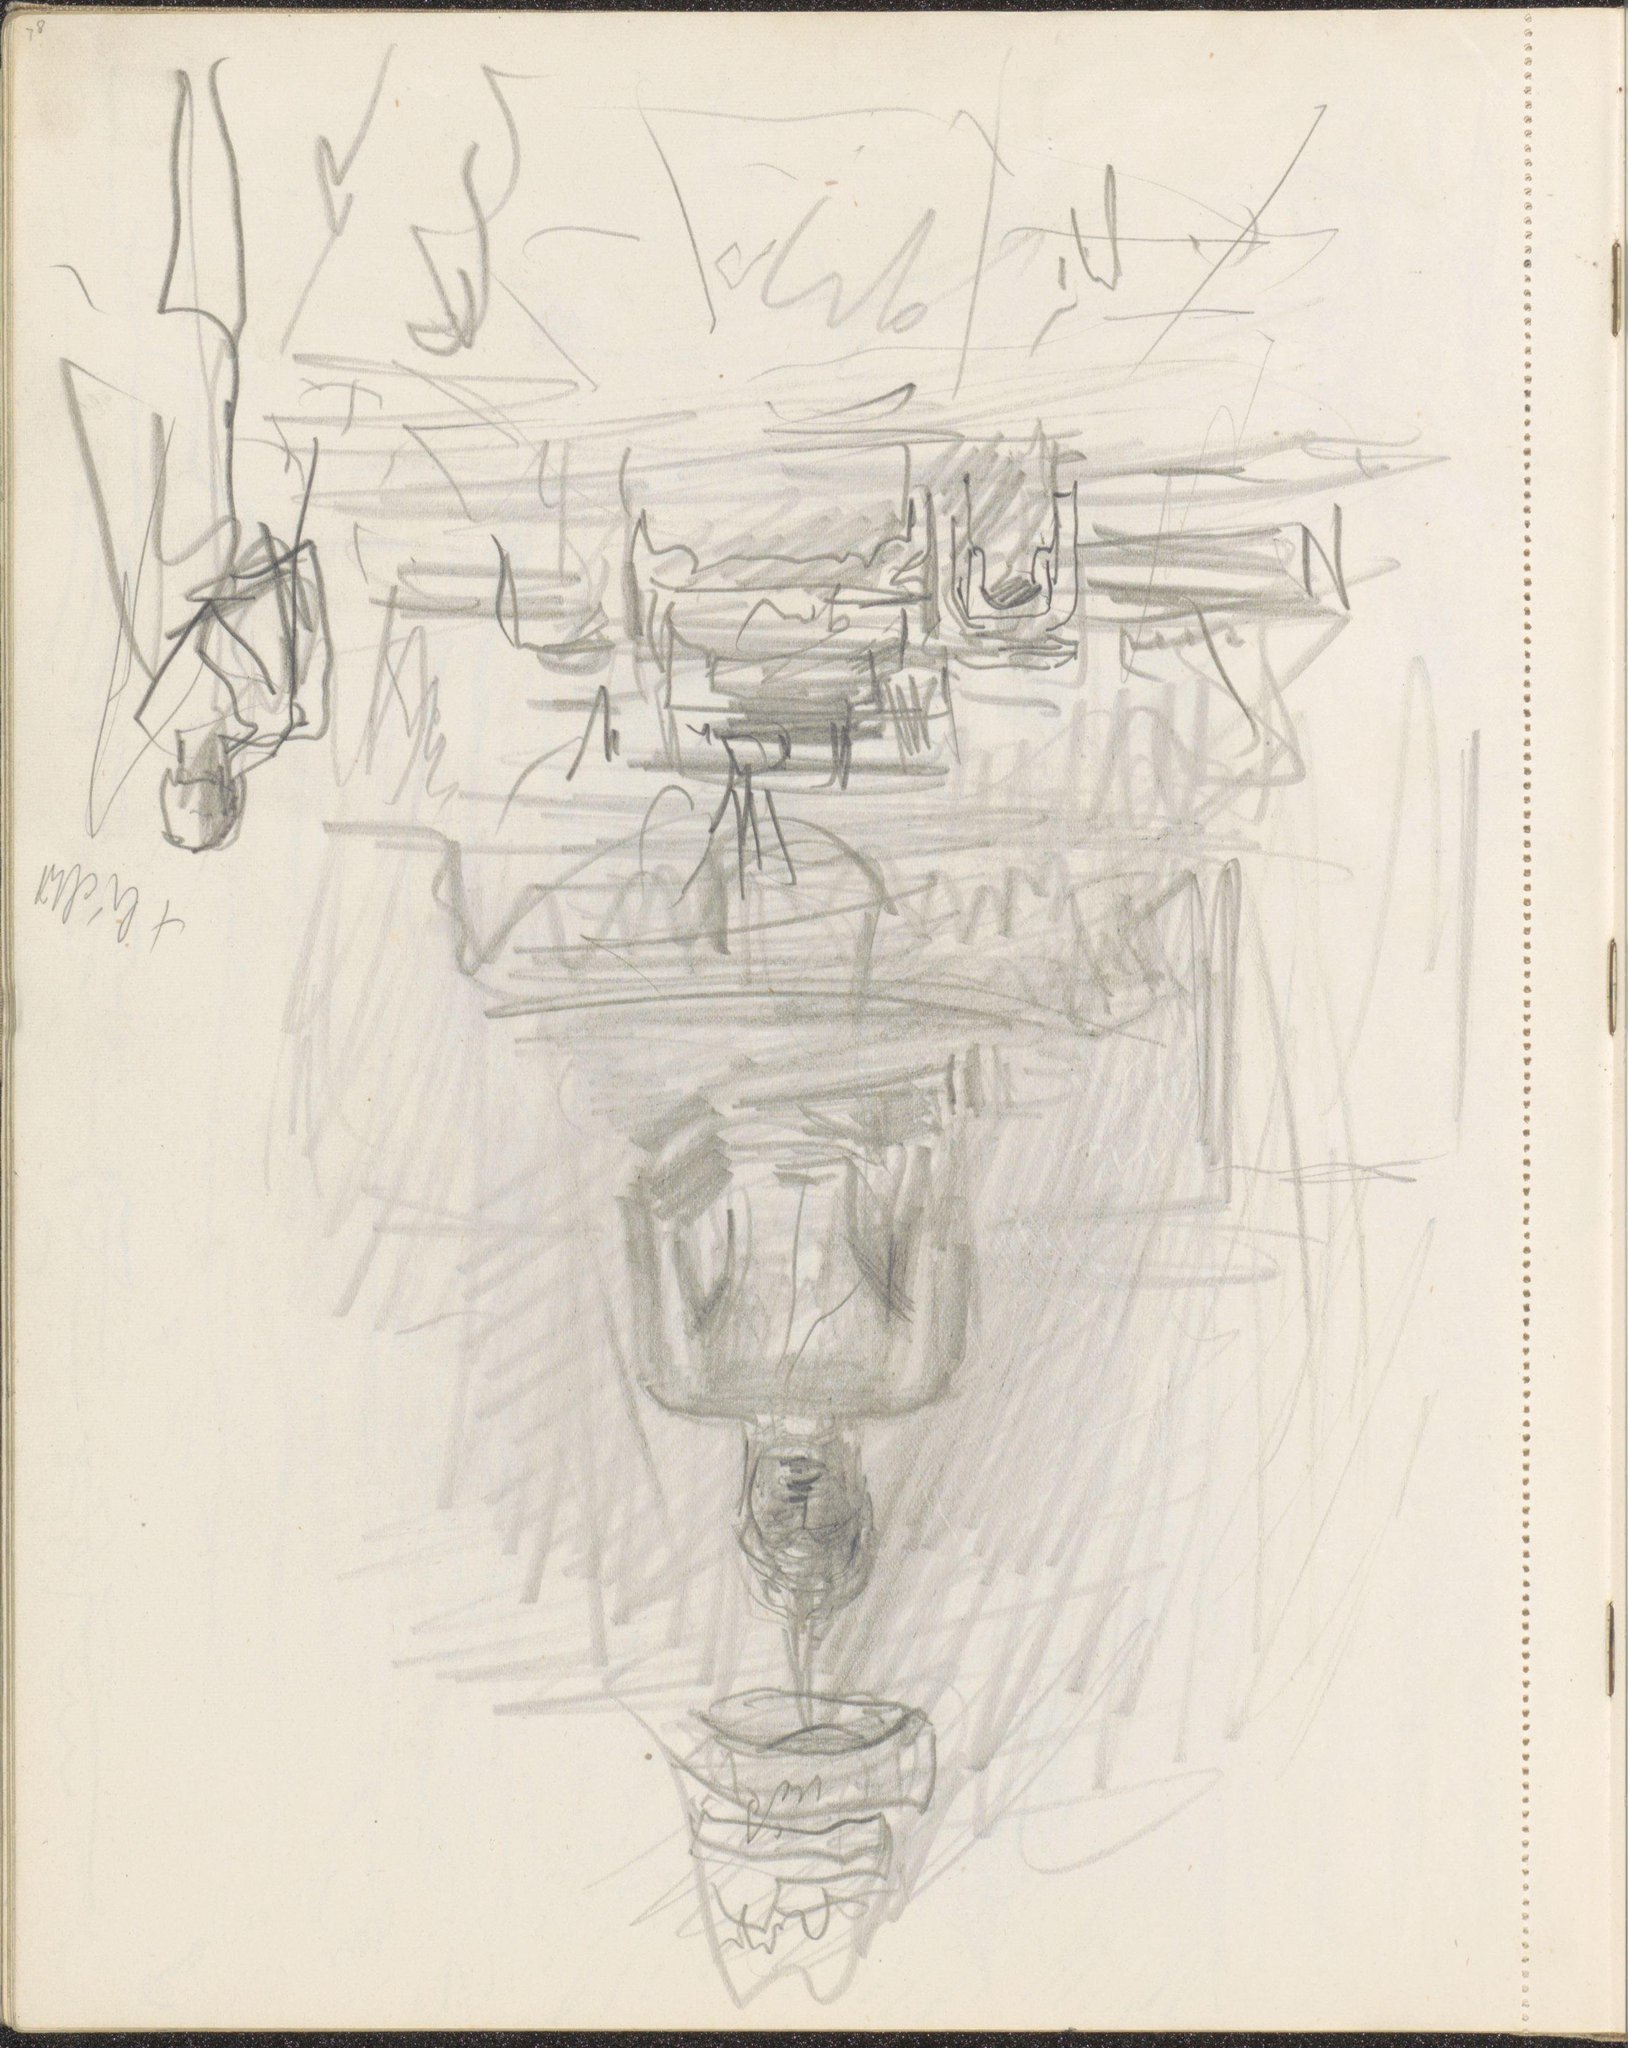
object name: sketchbook leaf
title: Monnik bij een altaar met een Boeddhabeeld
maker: marius bauer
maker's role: draughtsman, print maker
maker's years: 1867-1932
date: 1931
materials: paper, pencil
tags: altar ~ hinduism, buddhism, jainism, statues, paintings, etc. ~ objects of worship (hinduism, buddhism, jainism), religious functionaries ~ hinduism, buddhism, jainism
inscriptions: kleurnotitie, handgeschreven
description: Pagina 78 uit een schetsboek met 48 bladen.